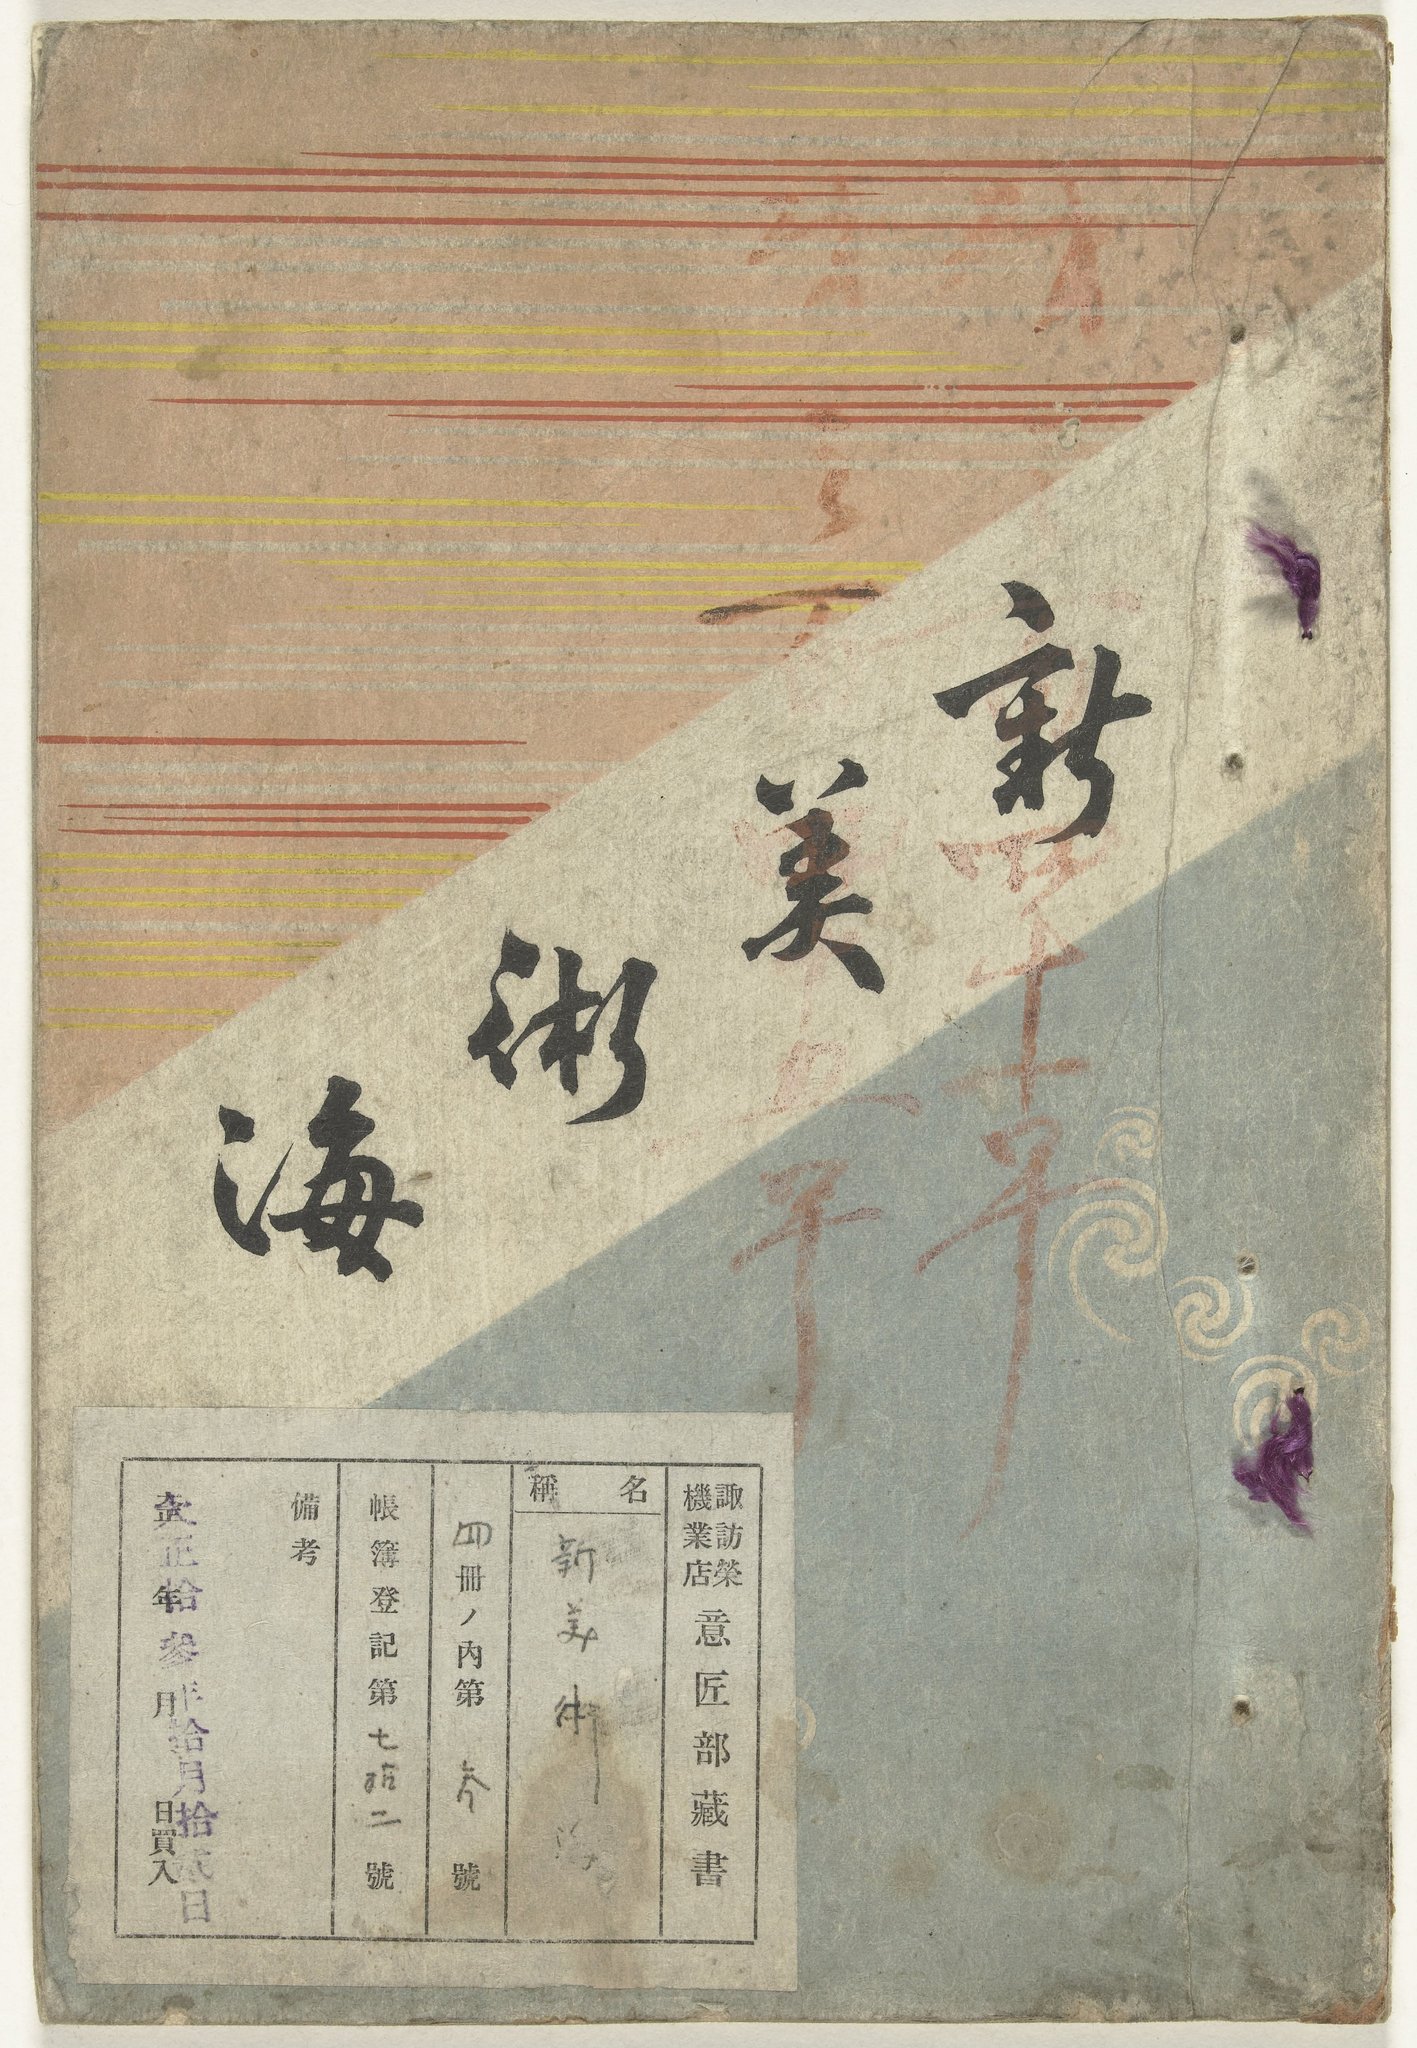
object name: book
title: Nieuwe zee der kunsten - 6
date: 1902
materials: paper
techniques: woodcut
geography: kyoto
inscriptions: date